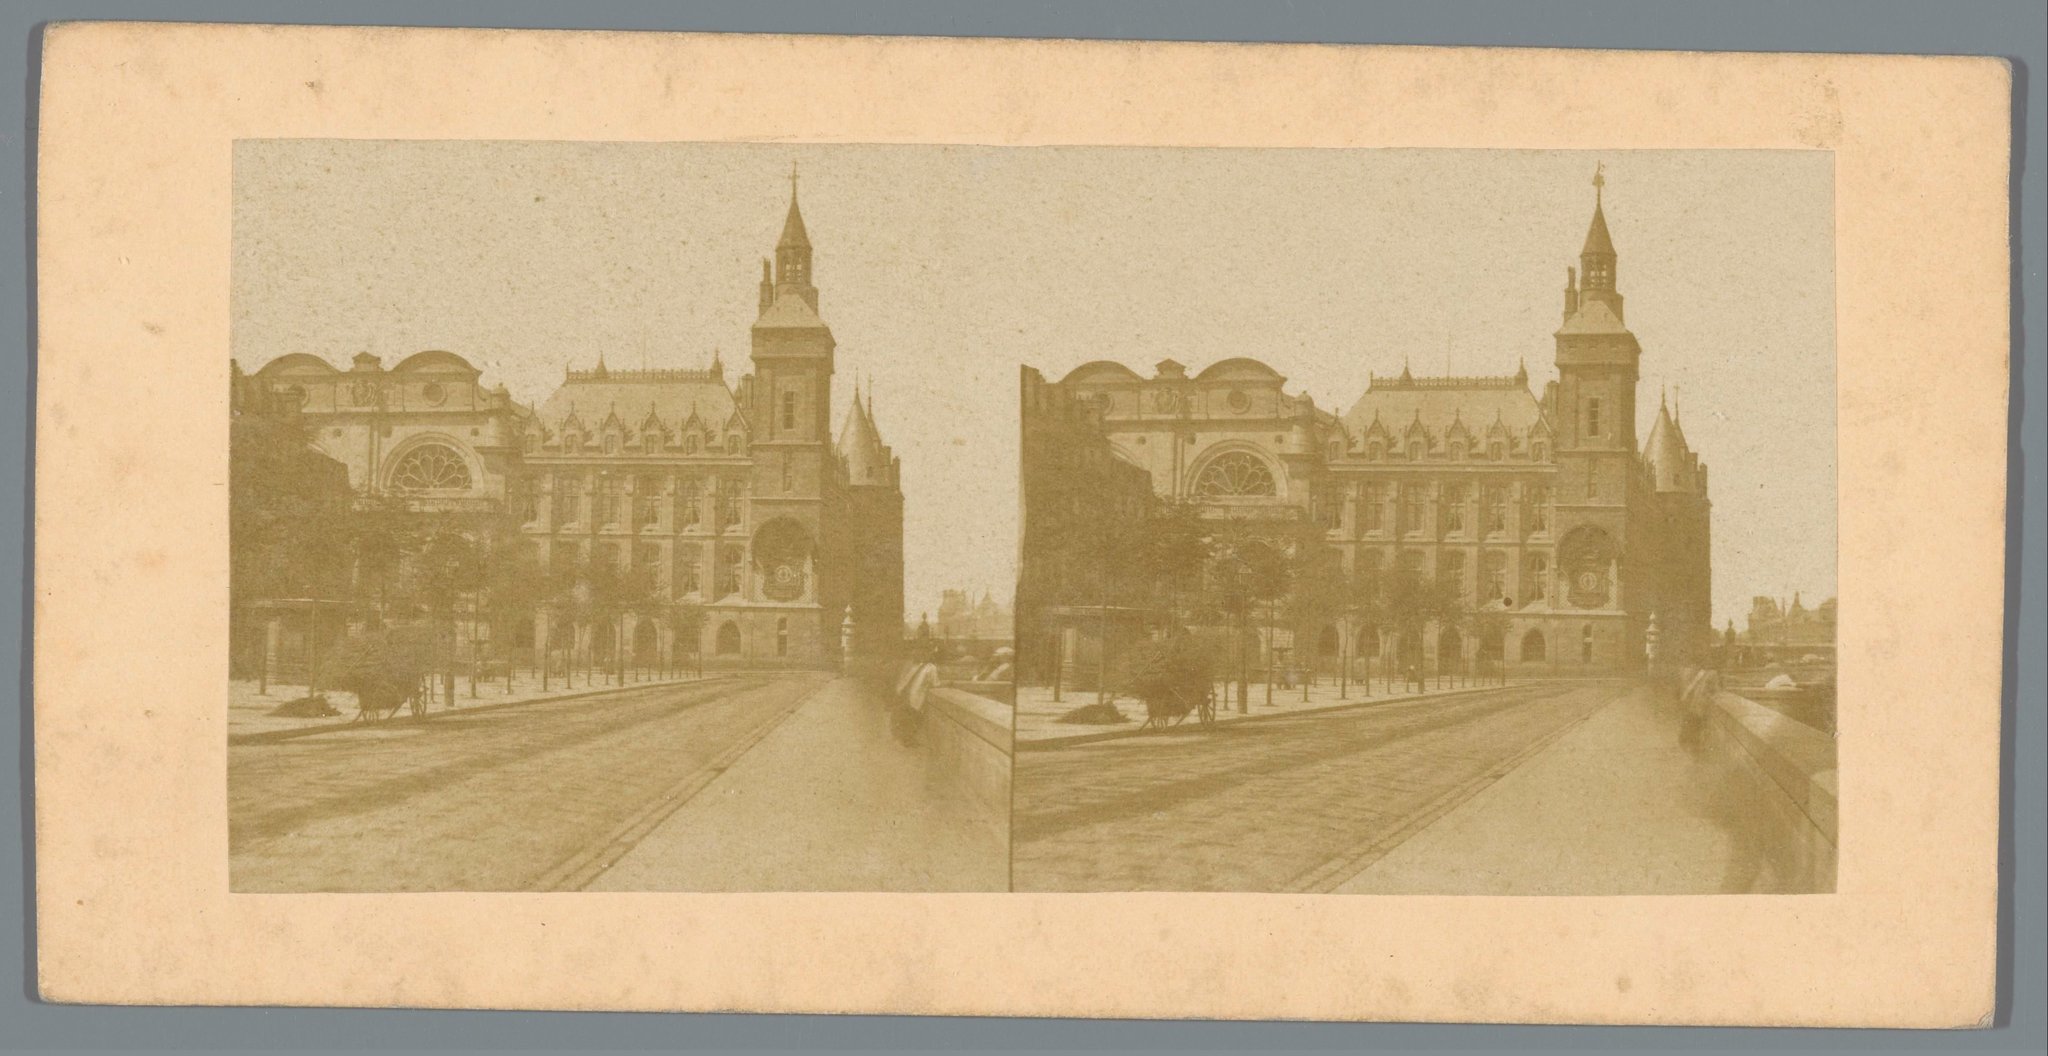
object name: stereograph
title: Gezicht op La Conciergerie in Parijs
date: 1860-1880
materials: cardboard, photographic support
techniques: albumen print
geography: paris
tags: tower, clock tower ~ monumental adornment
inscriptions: inscription: ‘Le Marche aux fleurs’